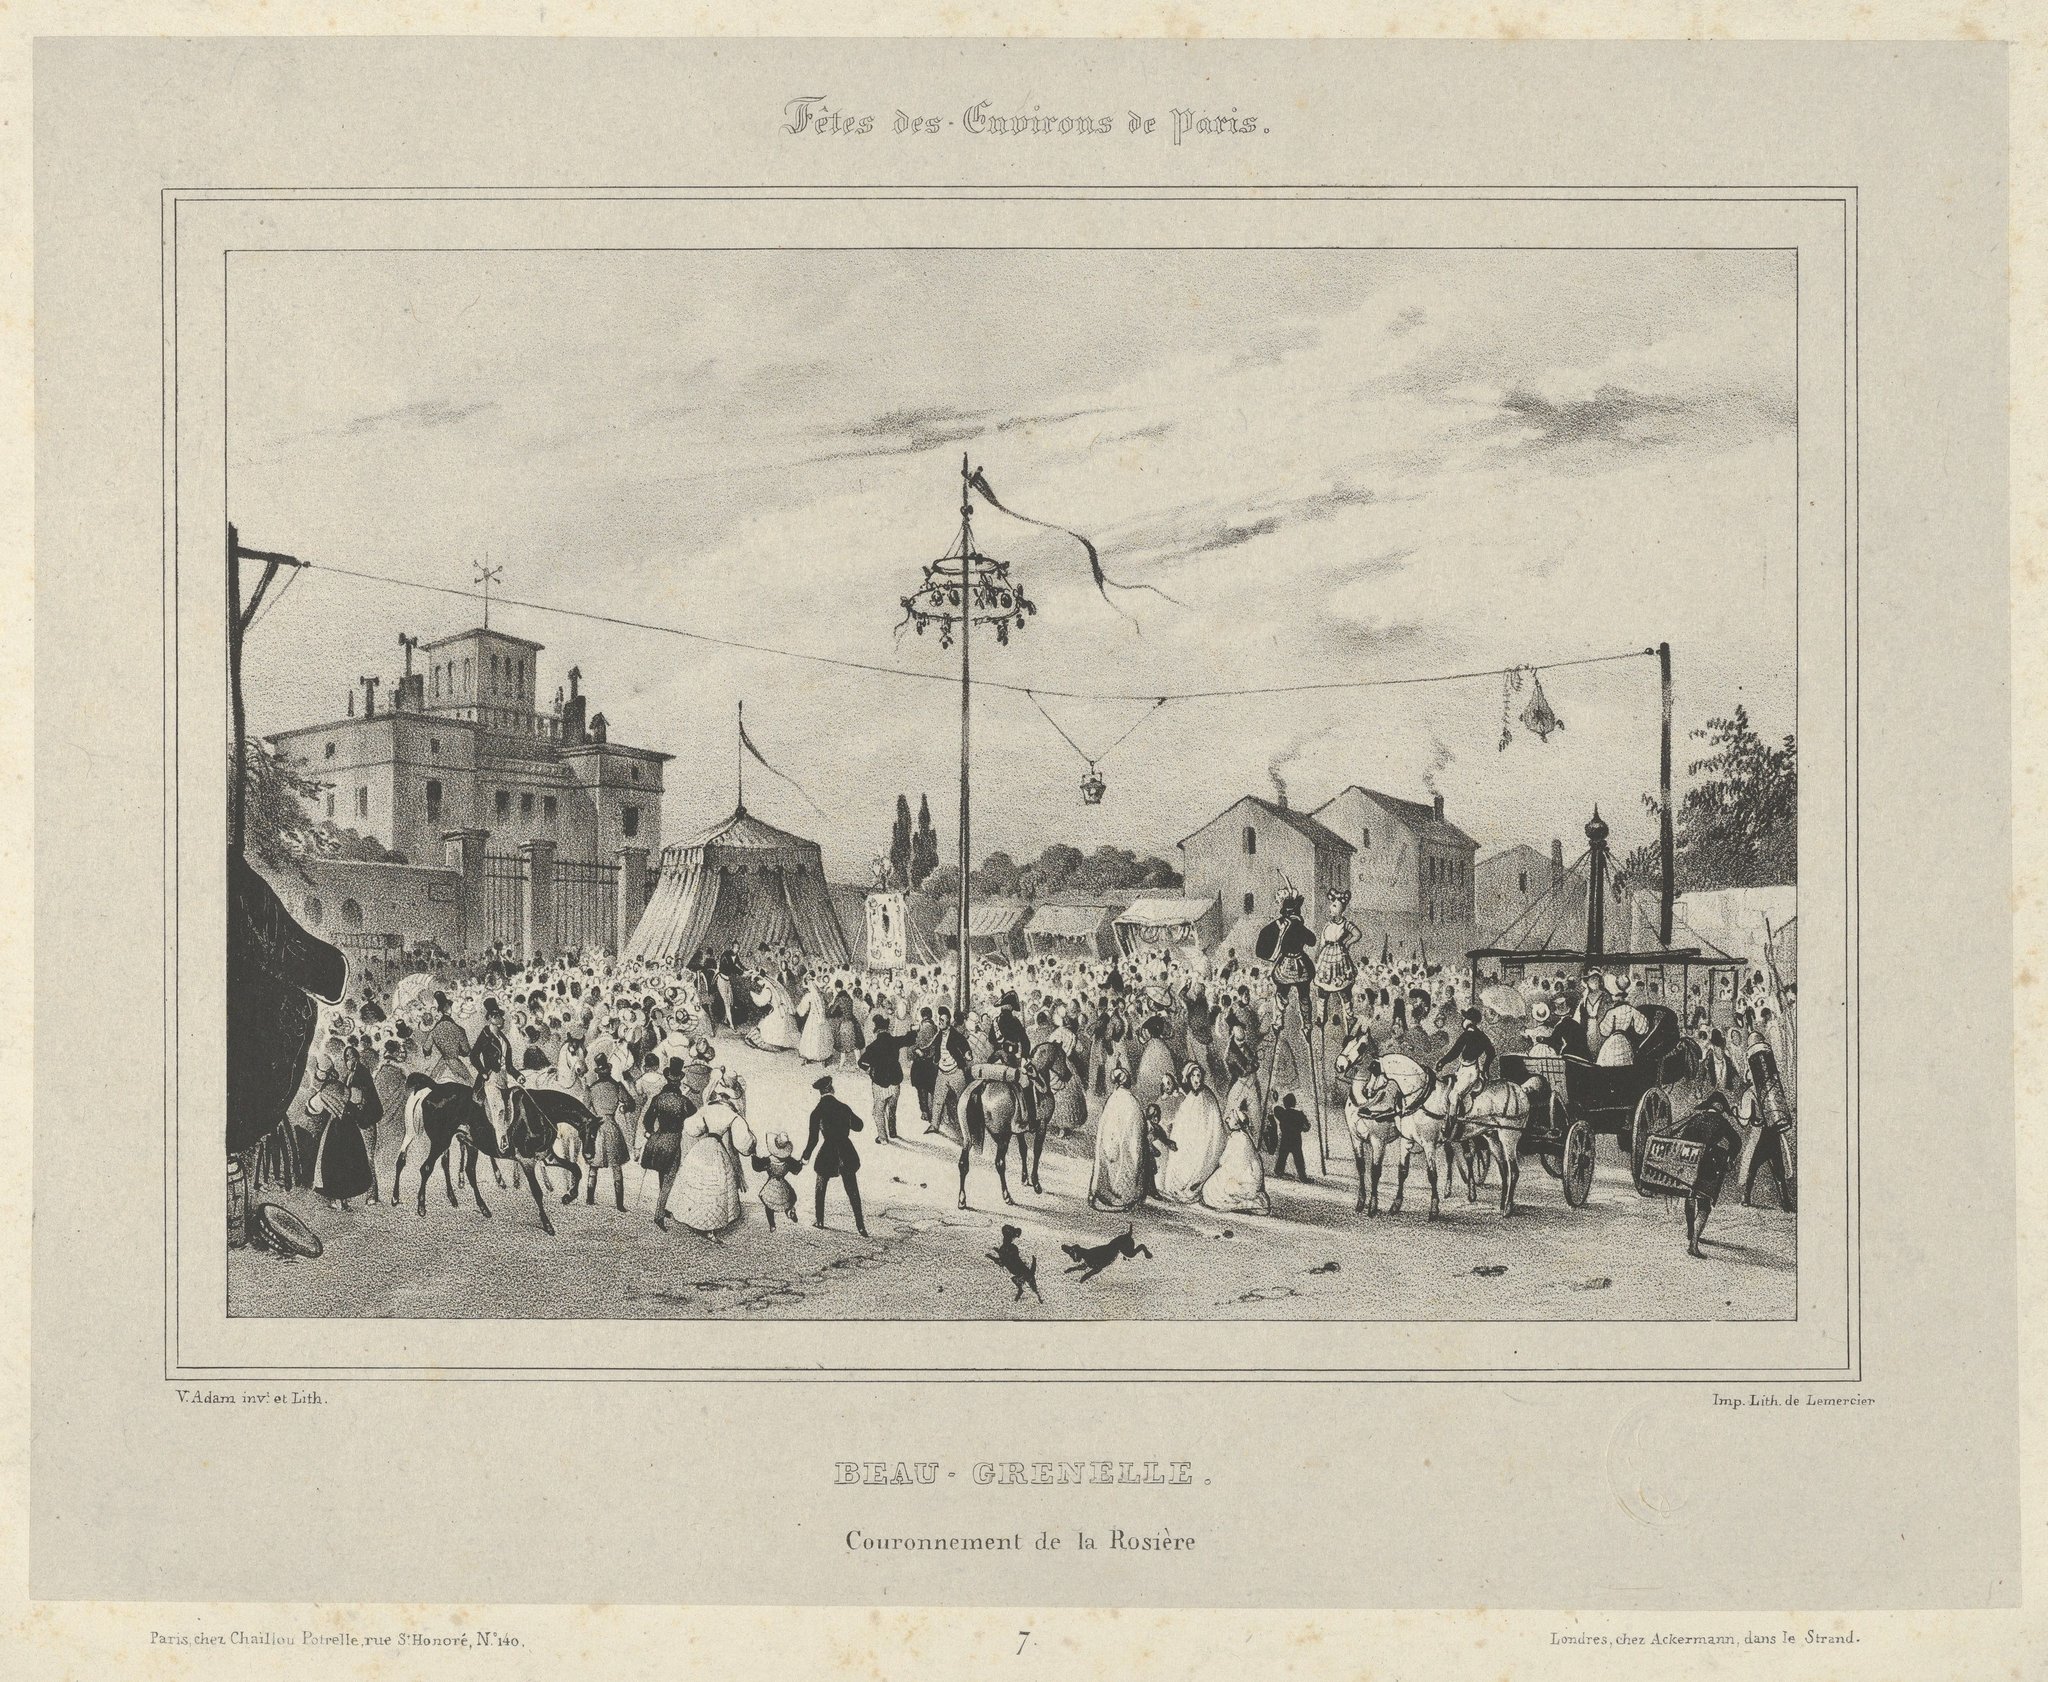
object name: print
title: Beau-Grenelle, Couronnement De La Rosière (Fêtes des Environs de Paris)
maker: victor adam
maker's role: artist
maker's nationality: french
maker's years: 1801-1866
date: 1830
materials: stone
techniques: lithograph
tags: animals,dogs,horses,ceremony,crowd,paris